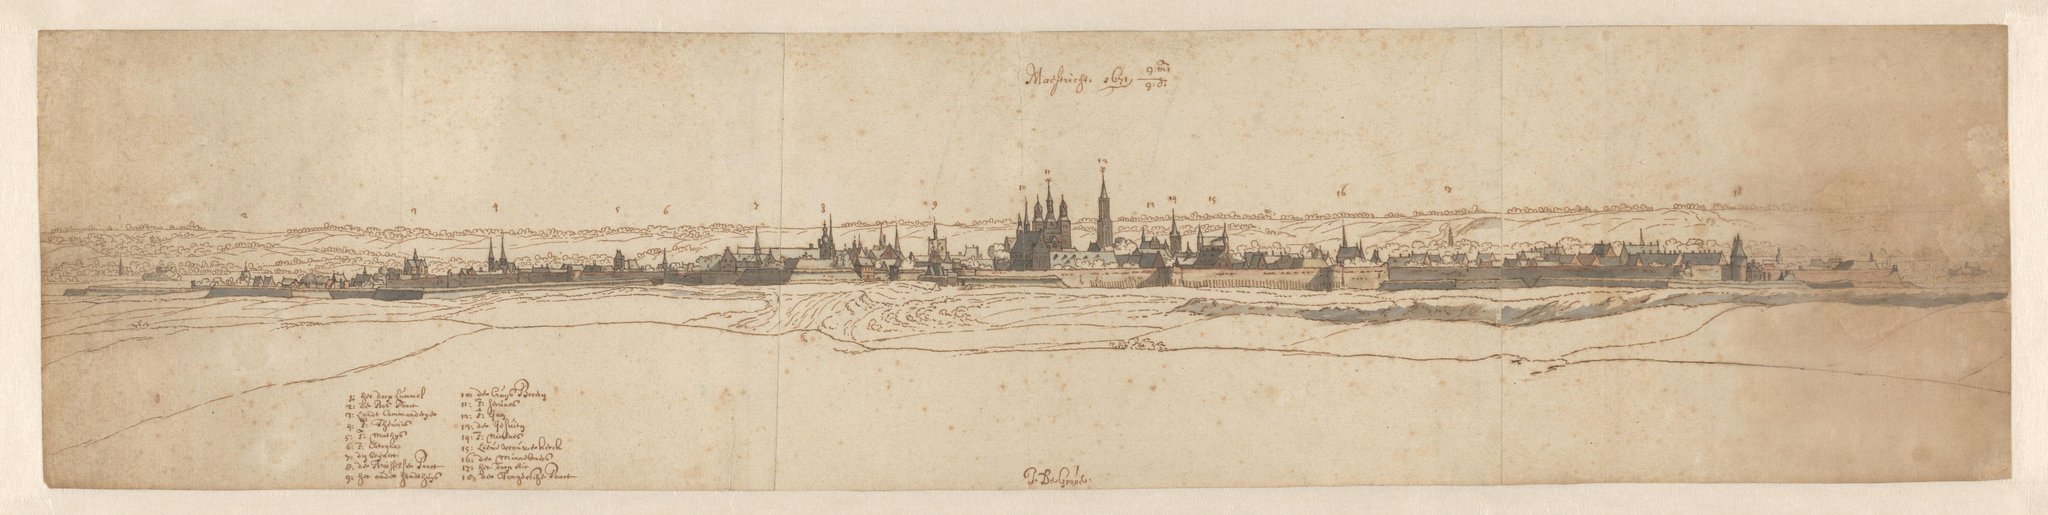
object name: drawing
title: Gezicht op Maastricht vanuit het noordwesten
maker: josua de grave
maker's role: draughtsman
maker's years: 1645-1712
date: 1671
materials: graphite, ink, paper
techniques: drawing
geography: maastricht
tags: maastricht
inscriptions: watermark